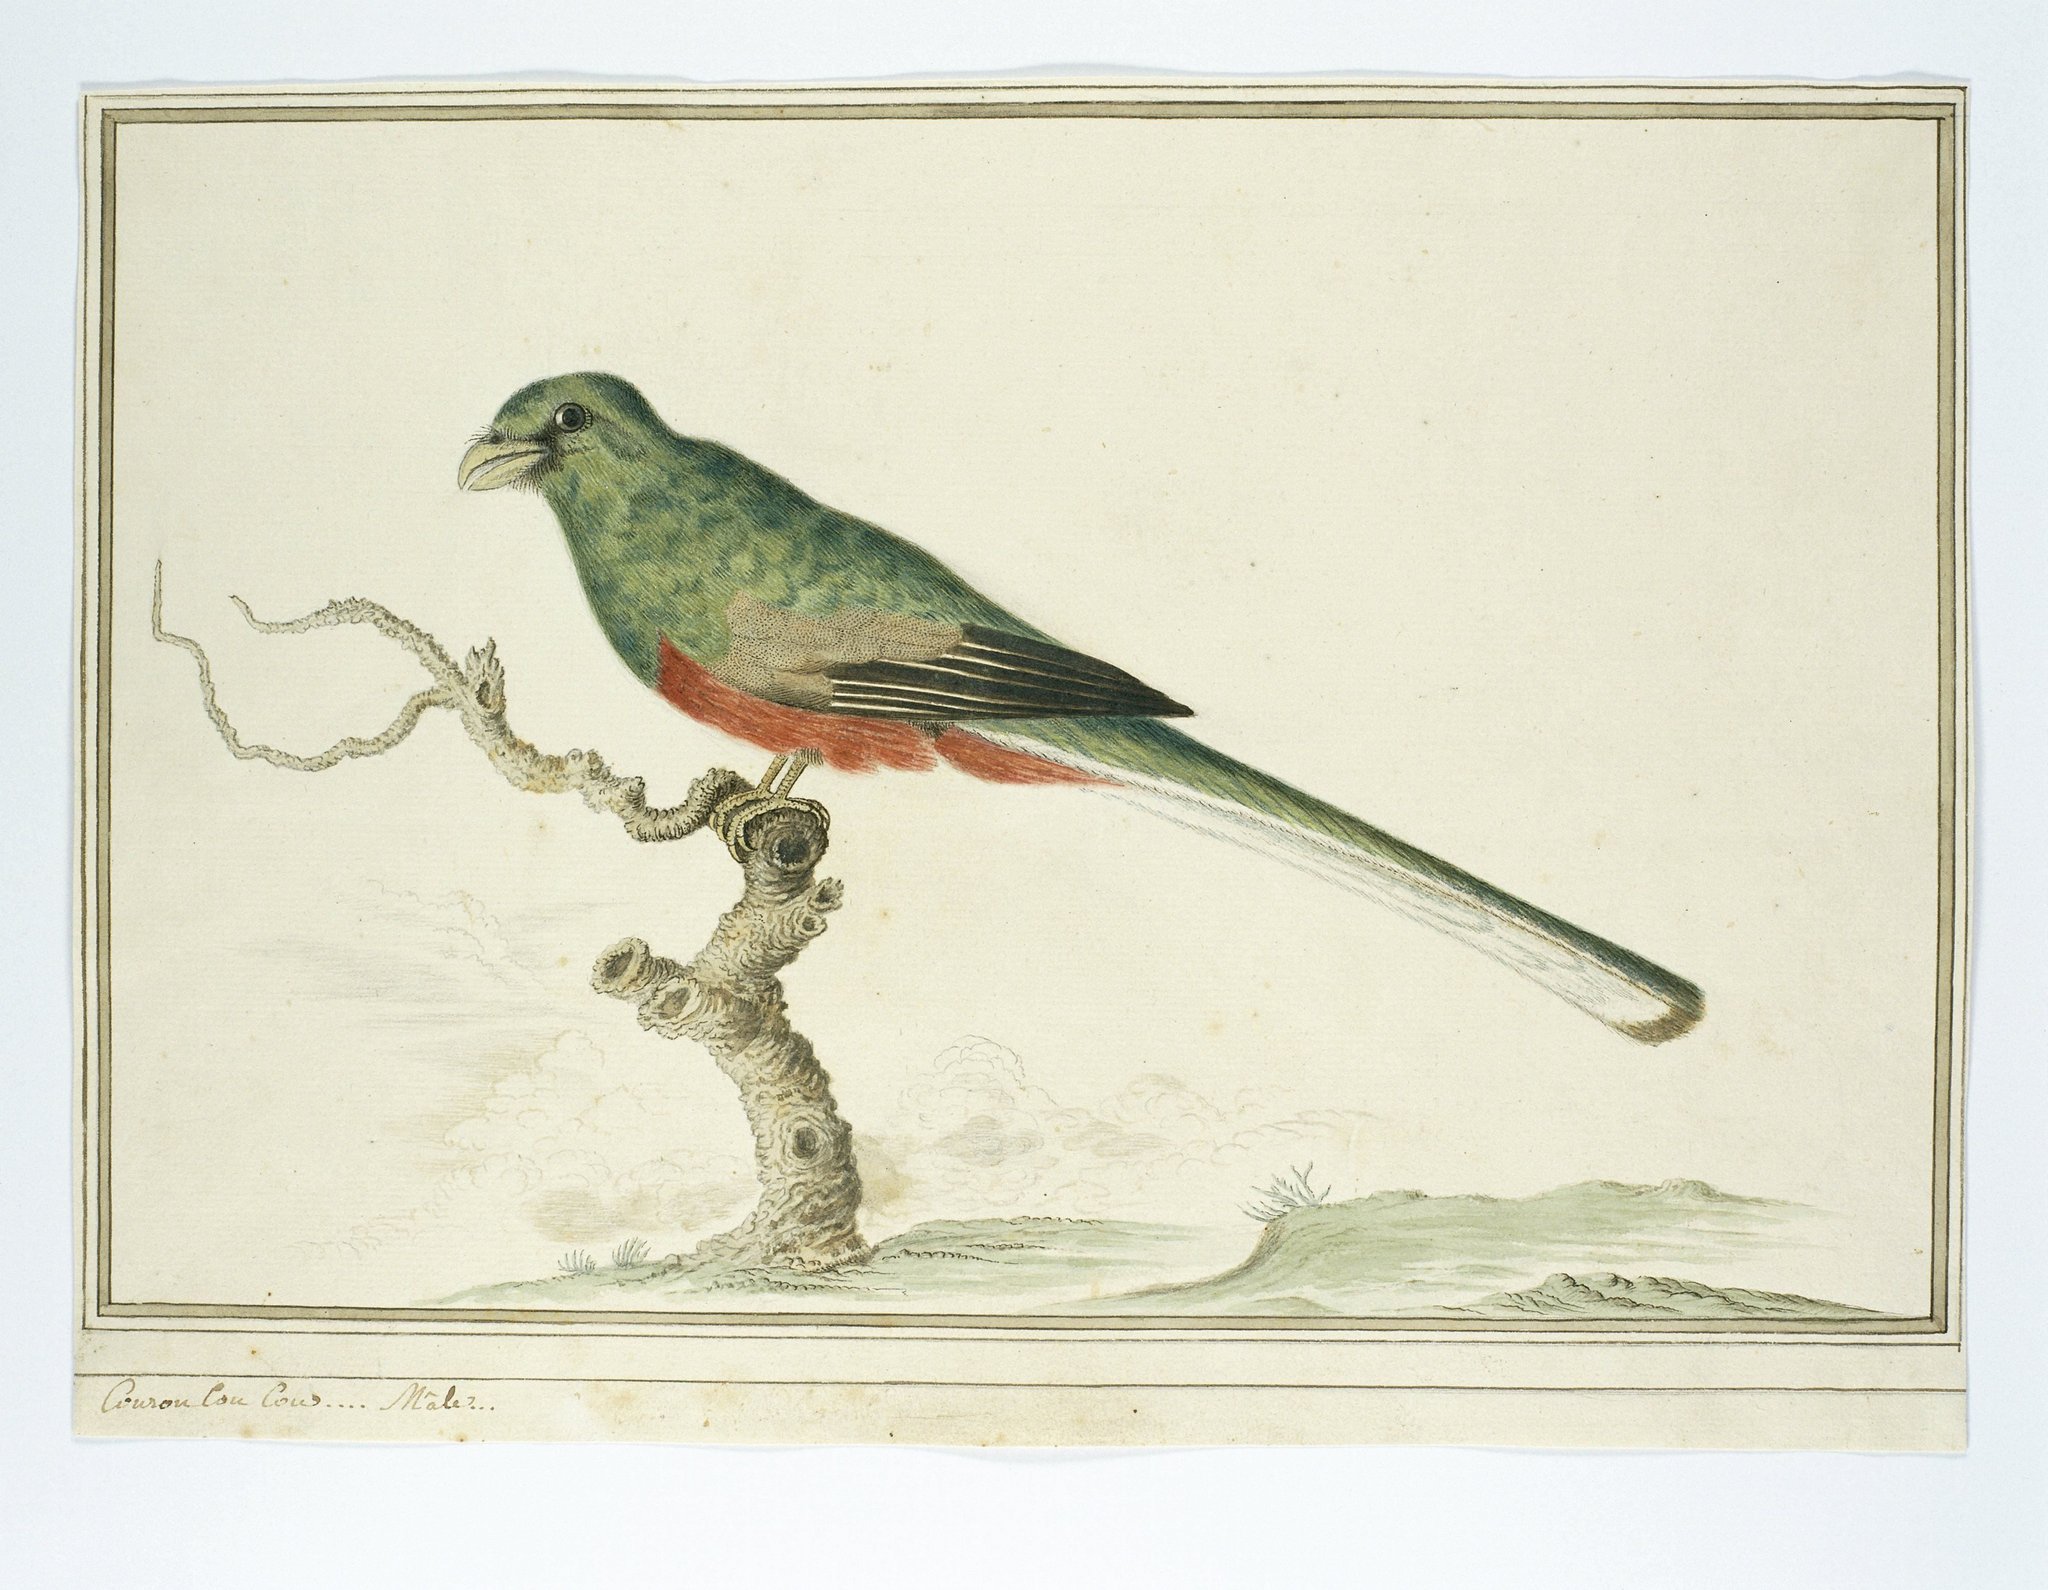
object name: album leaf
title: Apaloderma narina (Narina trogon)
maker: robert jacob gordon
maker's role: draughtsman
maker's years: 1743-1795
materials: paint, ink, paper, pencil, watercolor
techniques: brush, pen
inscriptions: annotation: ‘CourouCou Cou... Mâle.’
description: Vogelstudie: Bosloerie (Apaloderma narina); het mannetje. Er is slechts één soort trogon aanwezig in zuidelijk Afrika.